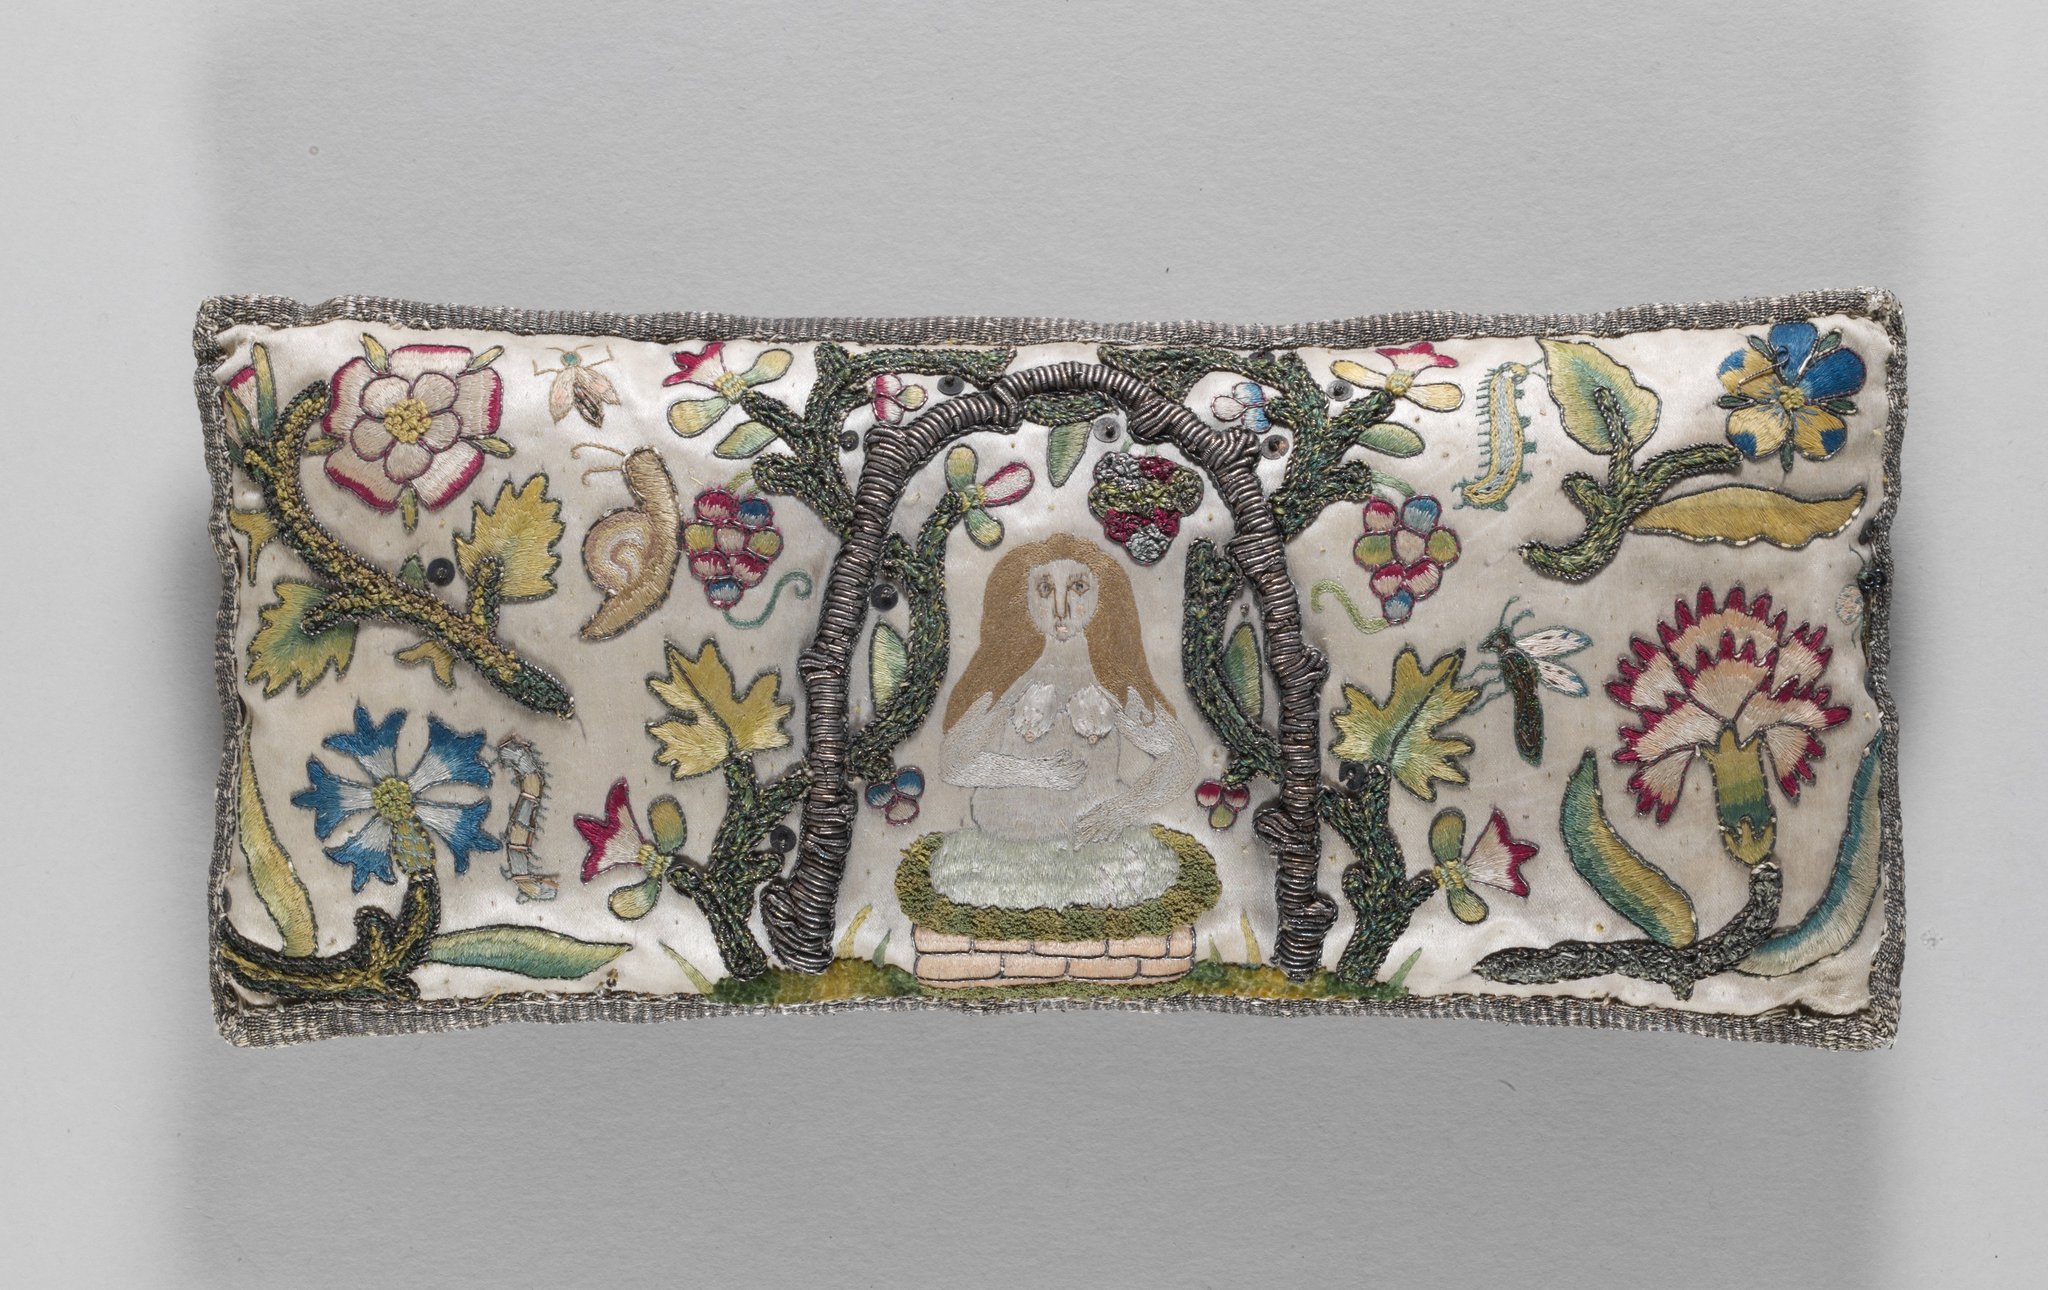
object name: cushion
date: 1634-1666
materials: metal thread, textile, silk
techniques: embroidery, stitching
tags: women,insects,snails,flowers,bathing